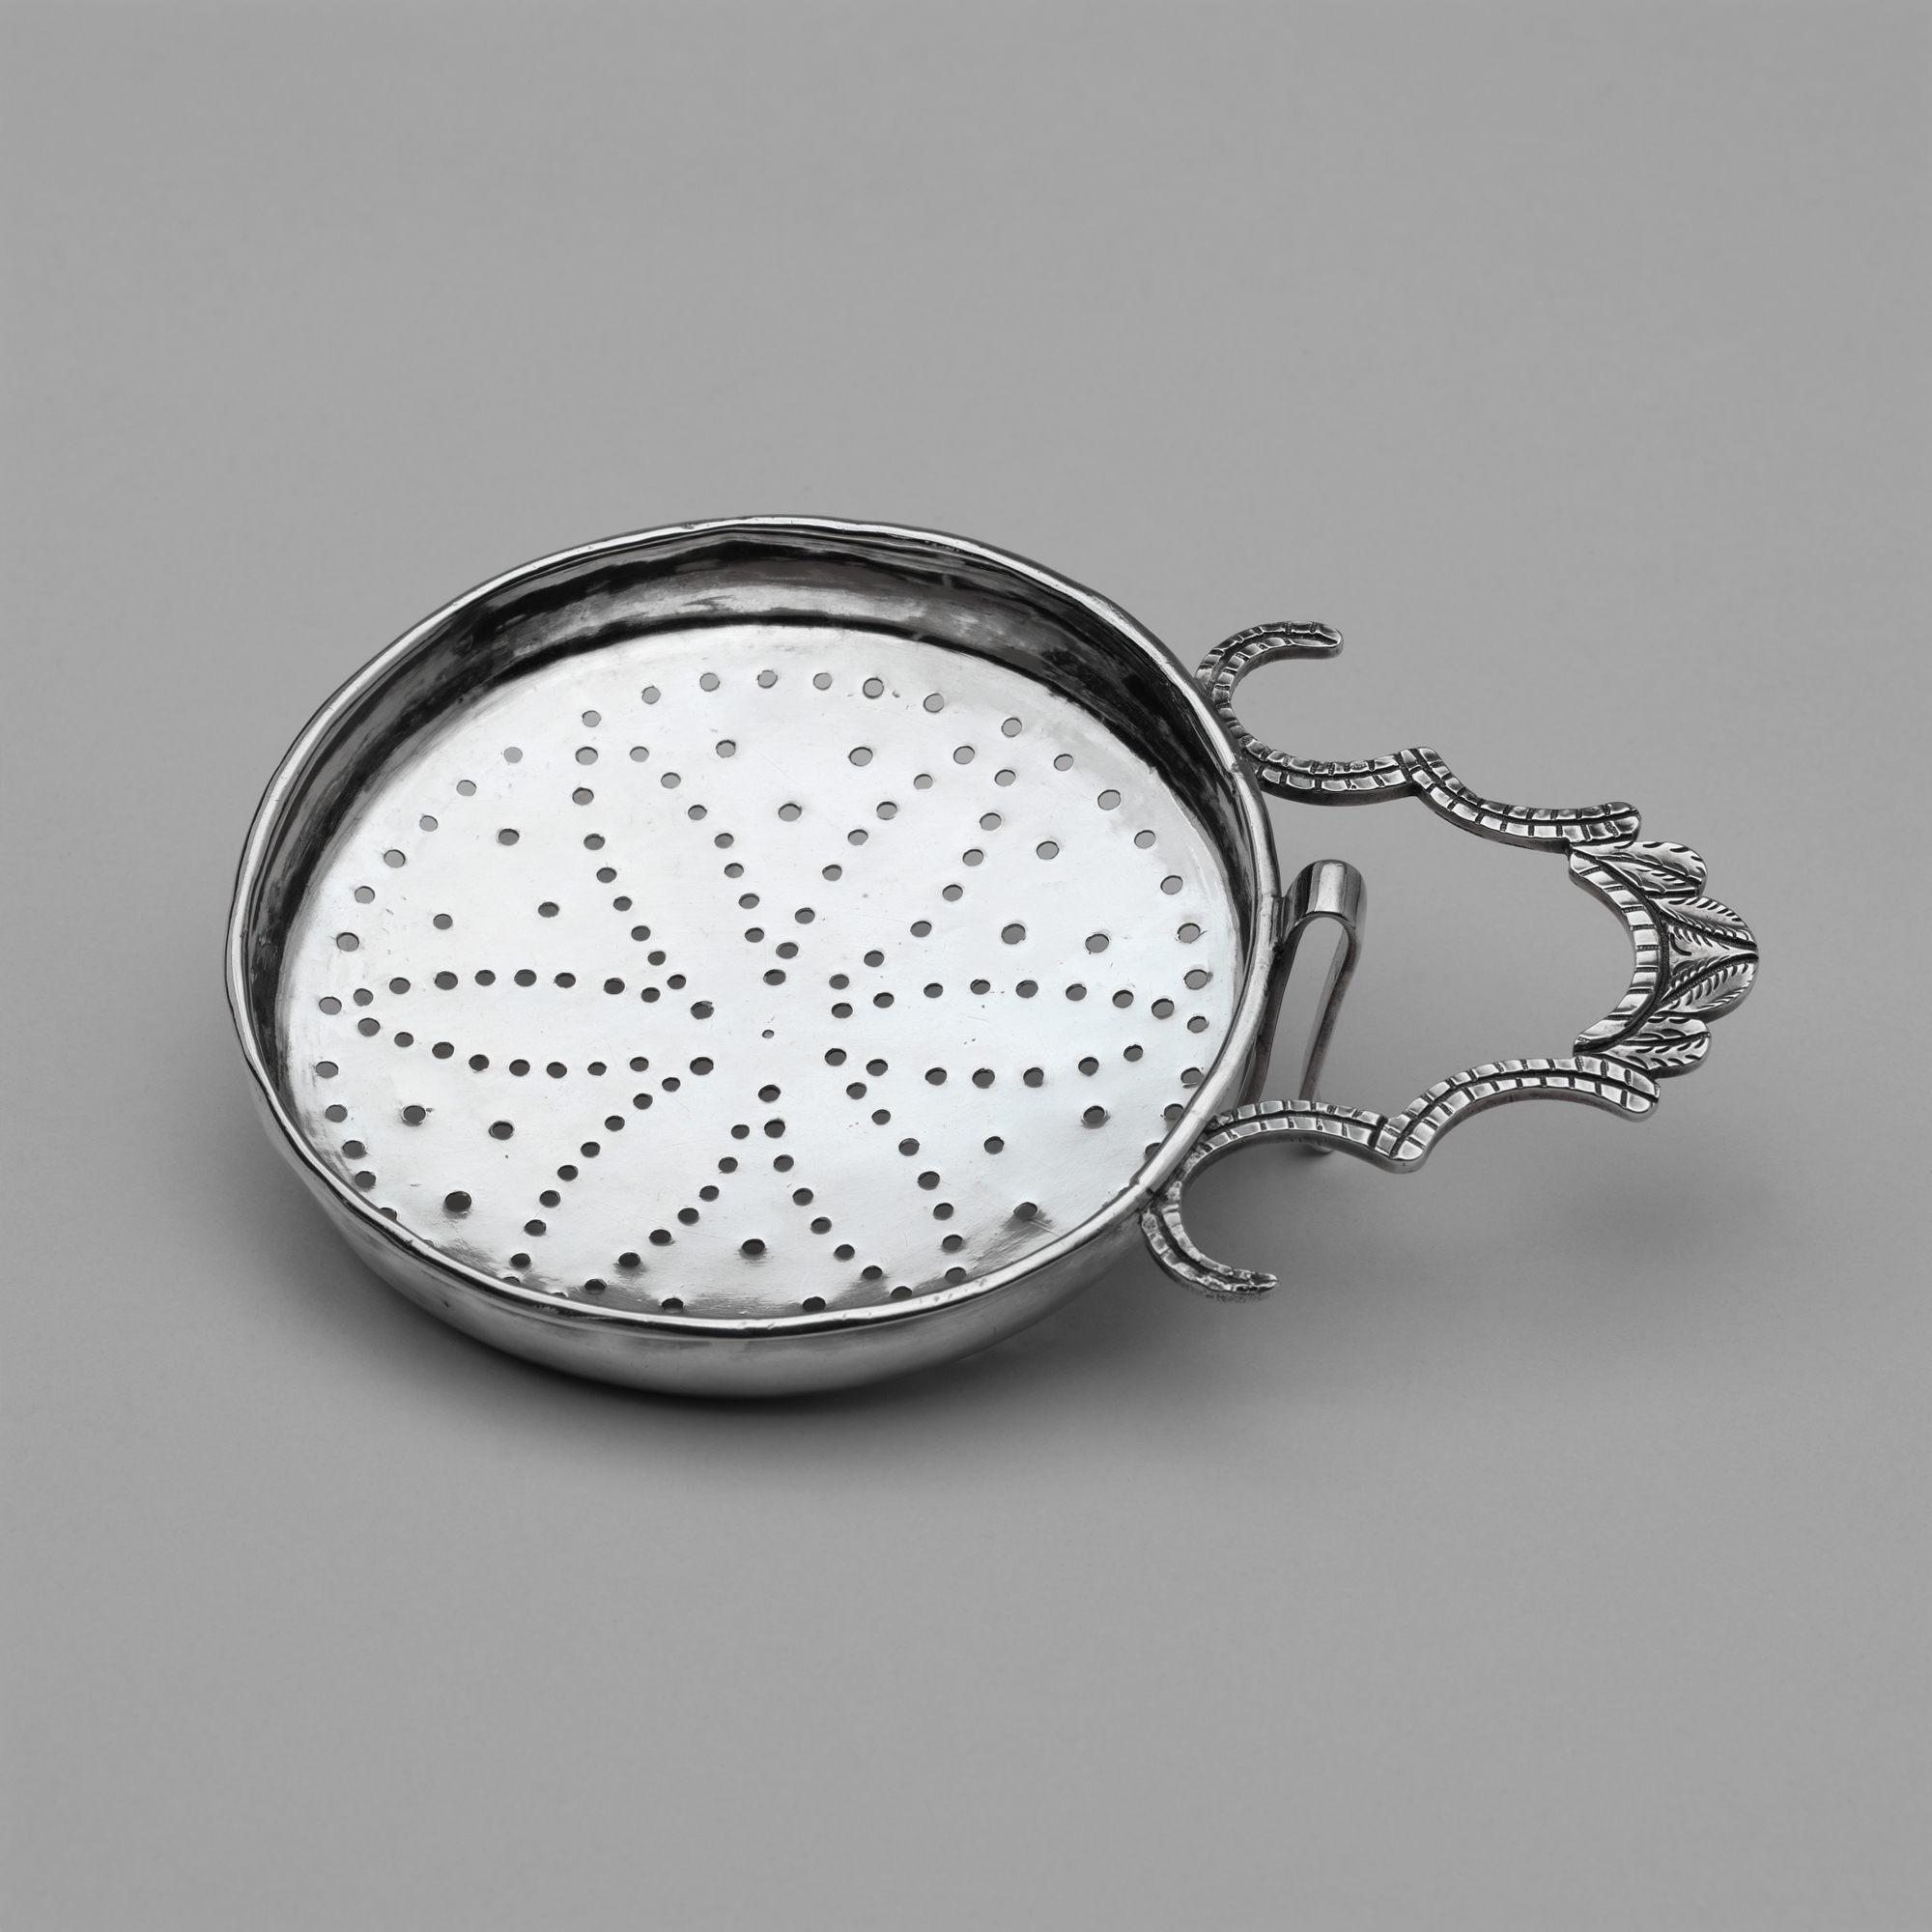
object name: strainer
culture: american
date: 1800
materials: silver